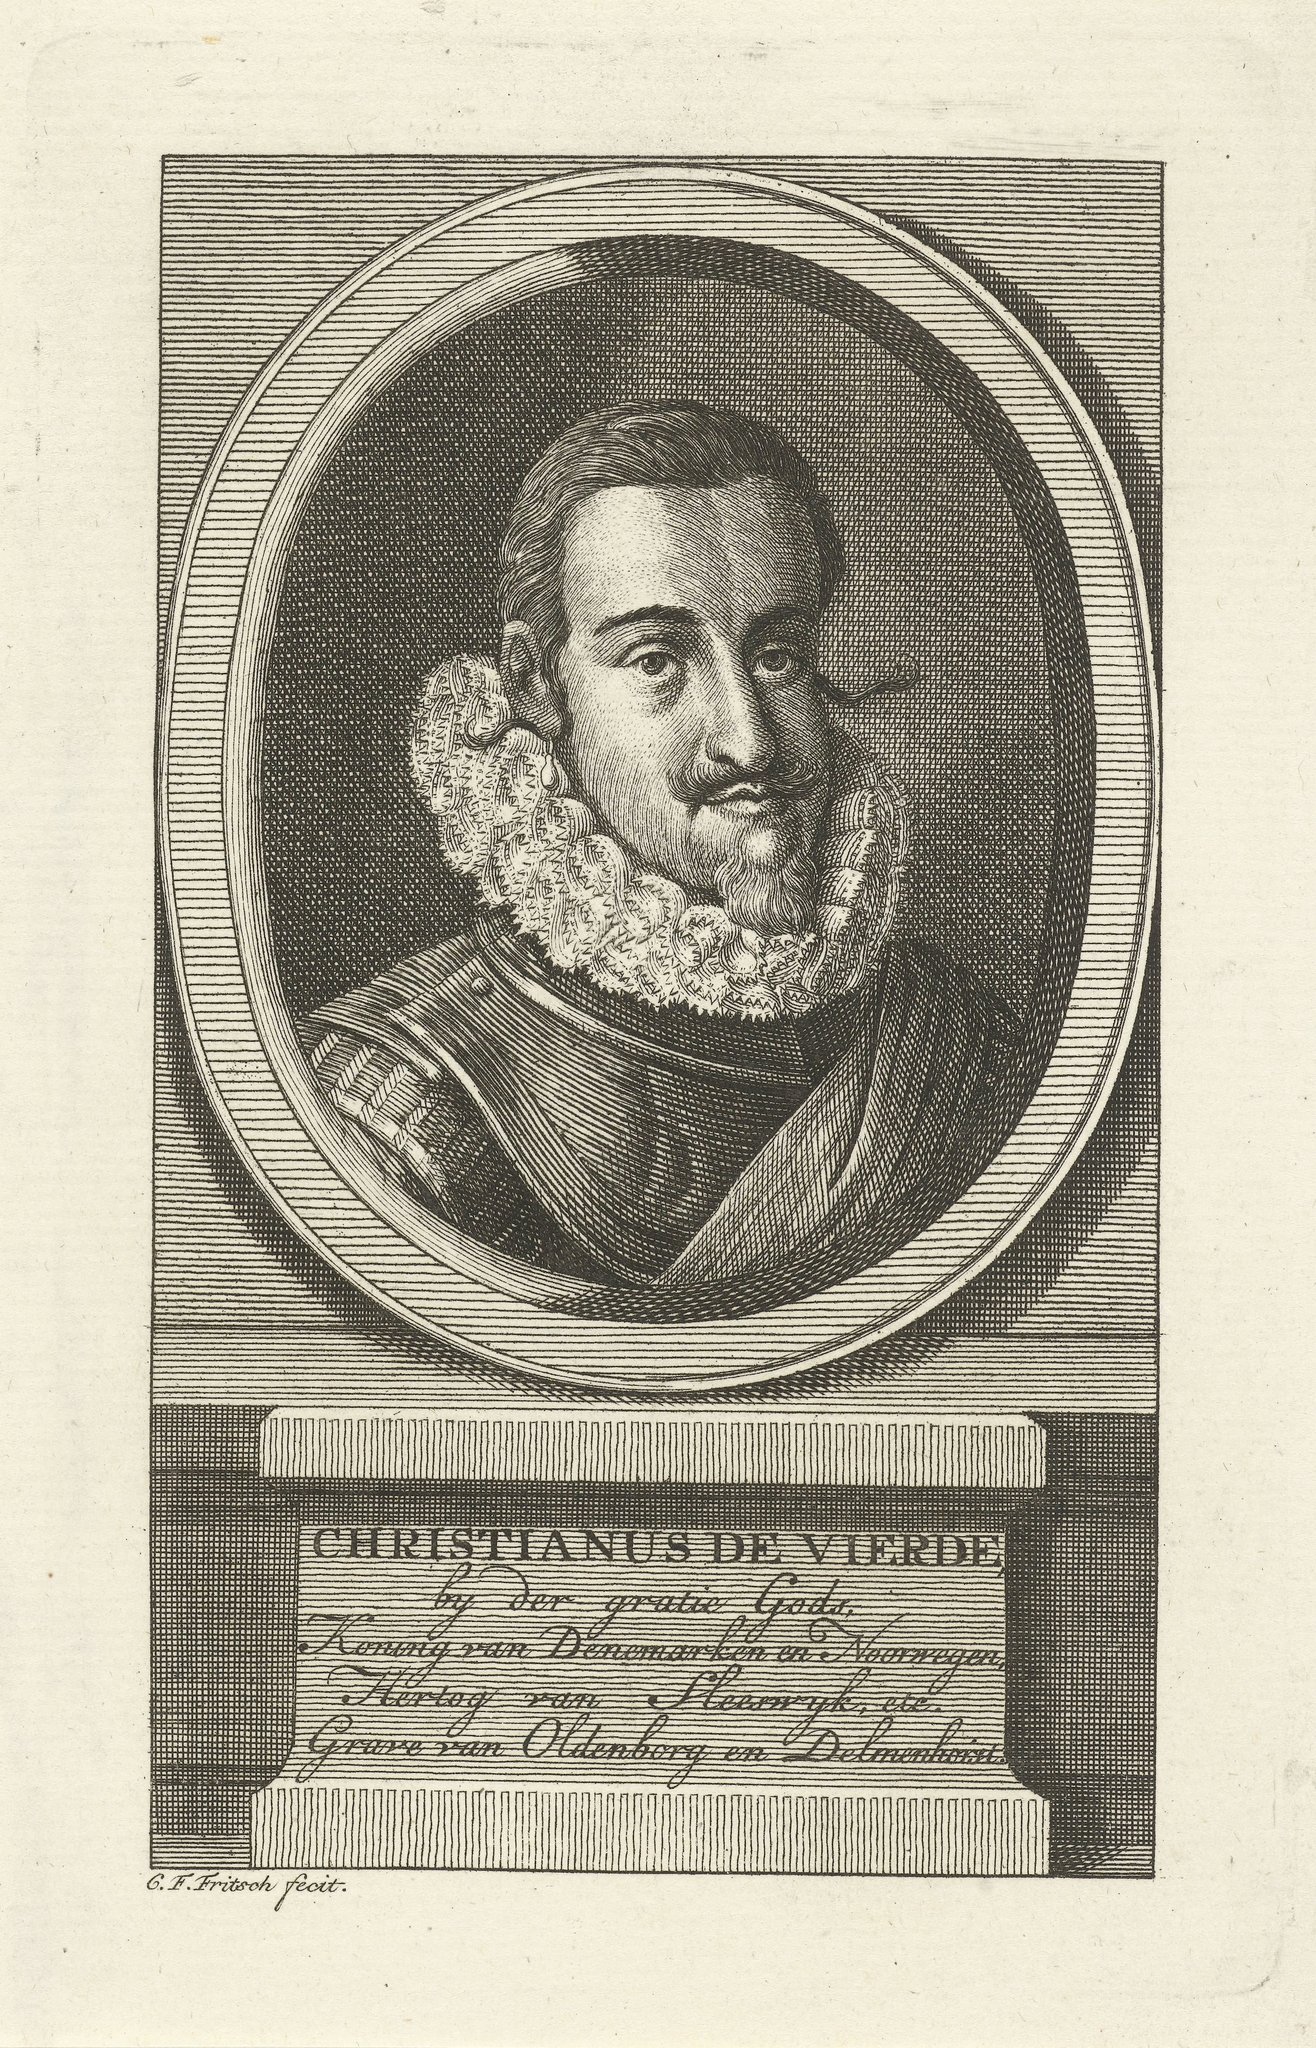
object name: print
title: Portret van Christiaan IV, koning van Denemarken en Noorwegen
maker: christian friedrich fritzsch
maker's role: print maker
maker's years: 1719-1774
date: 1753-1774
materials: paper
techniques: etching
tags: copenhagen (city), christiaan iv (koning van denemarken en noorwegen), neck-gear: collar (+ men's clothes)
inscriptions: collector's mark: Lugt 2228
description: Portret opgenomen in: Meteren, Emanuel van. Historie van de oorlogen en geschiedenissen der Nederlanderen, en der zelver Naburen: beginnende met den Jare 1315, en eindigende met den Jare 1611, deel 6 van 10. Amsterdam: Steven Jacobus Baalde, 1786.